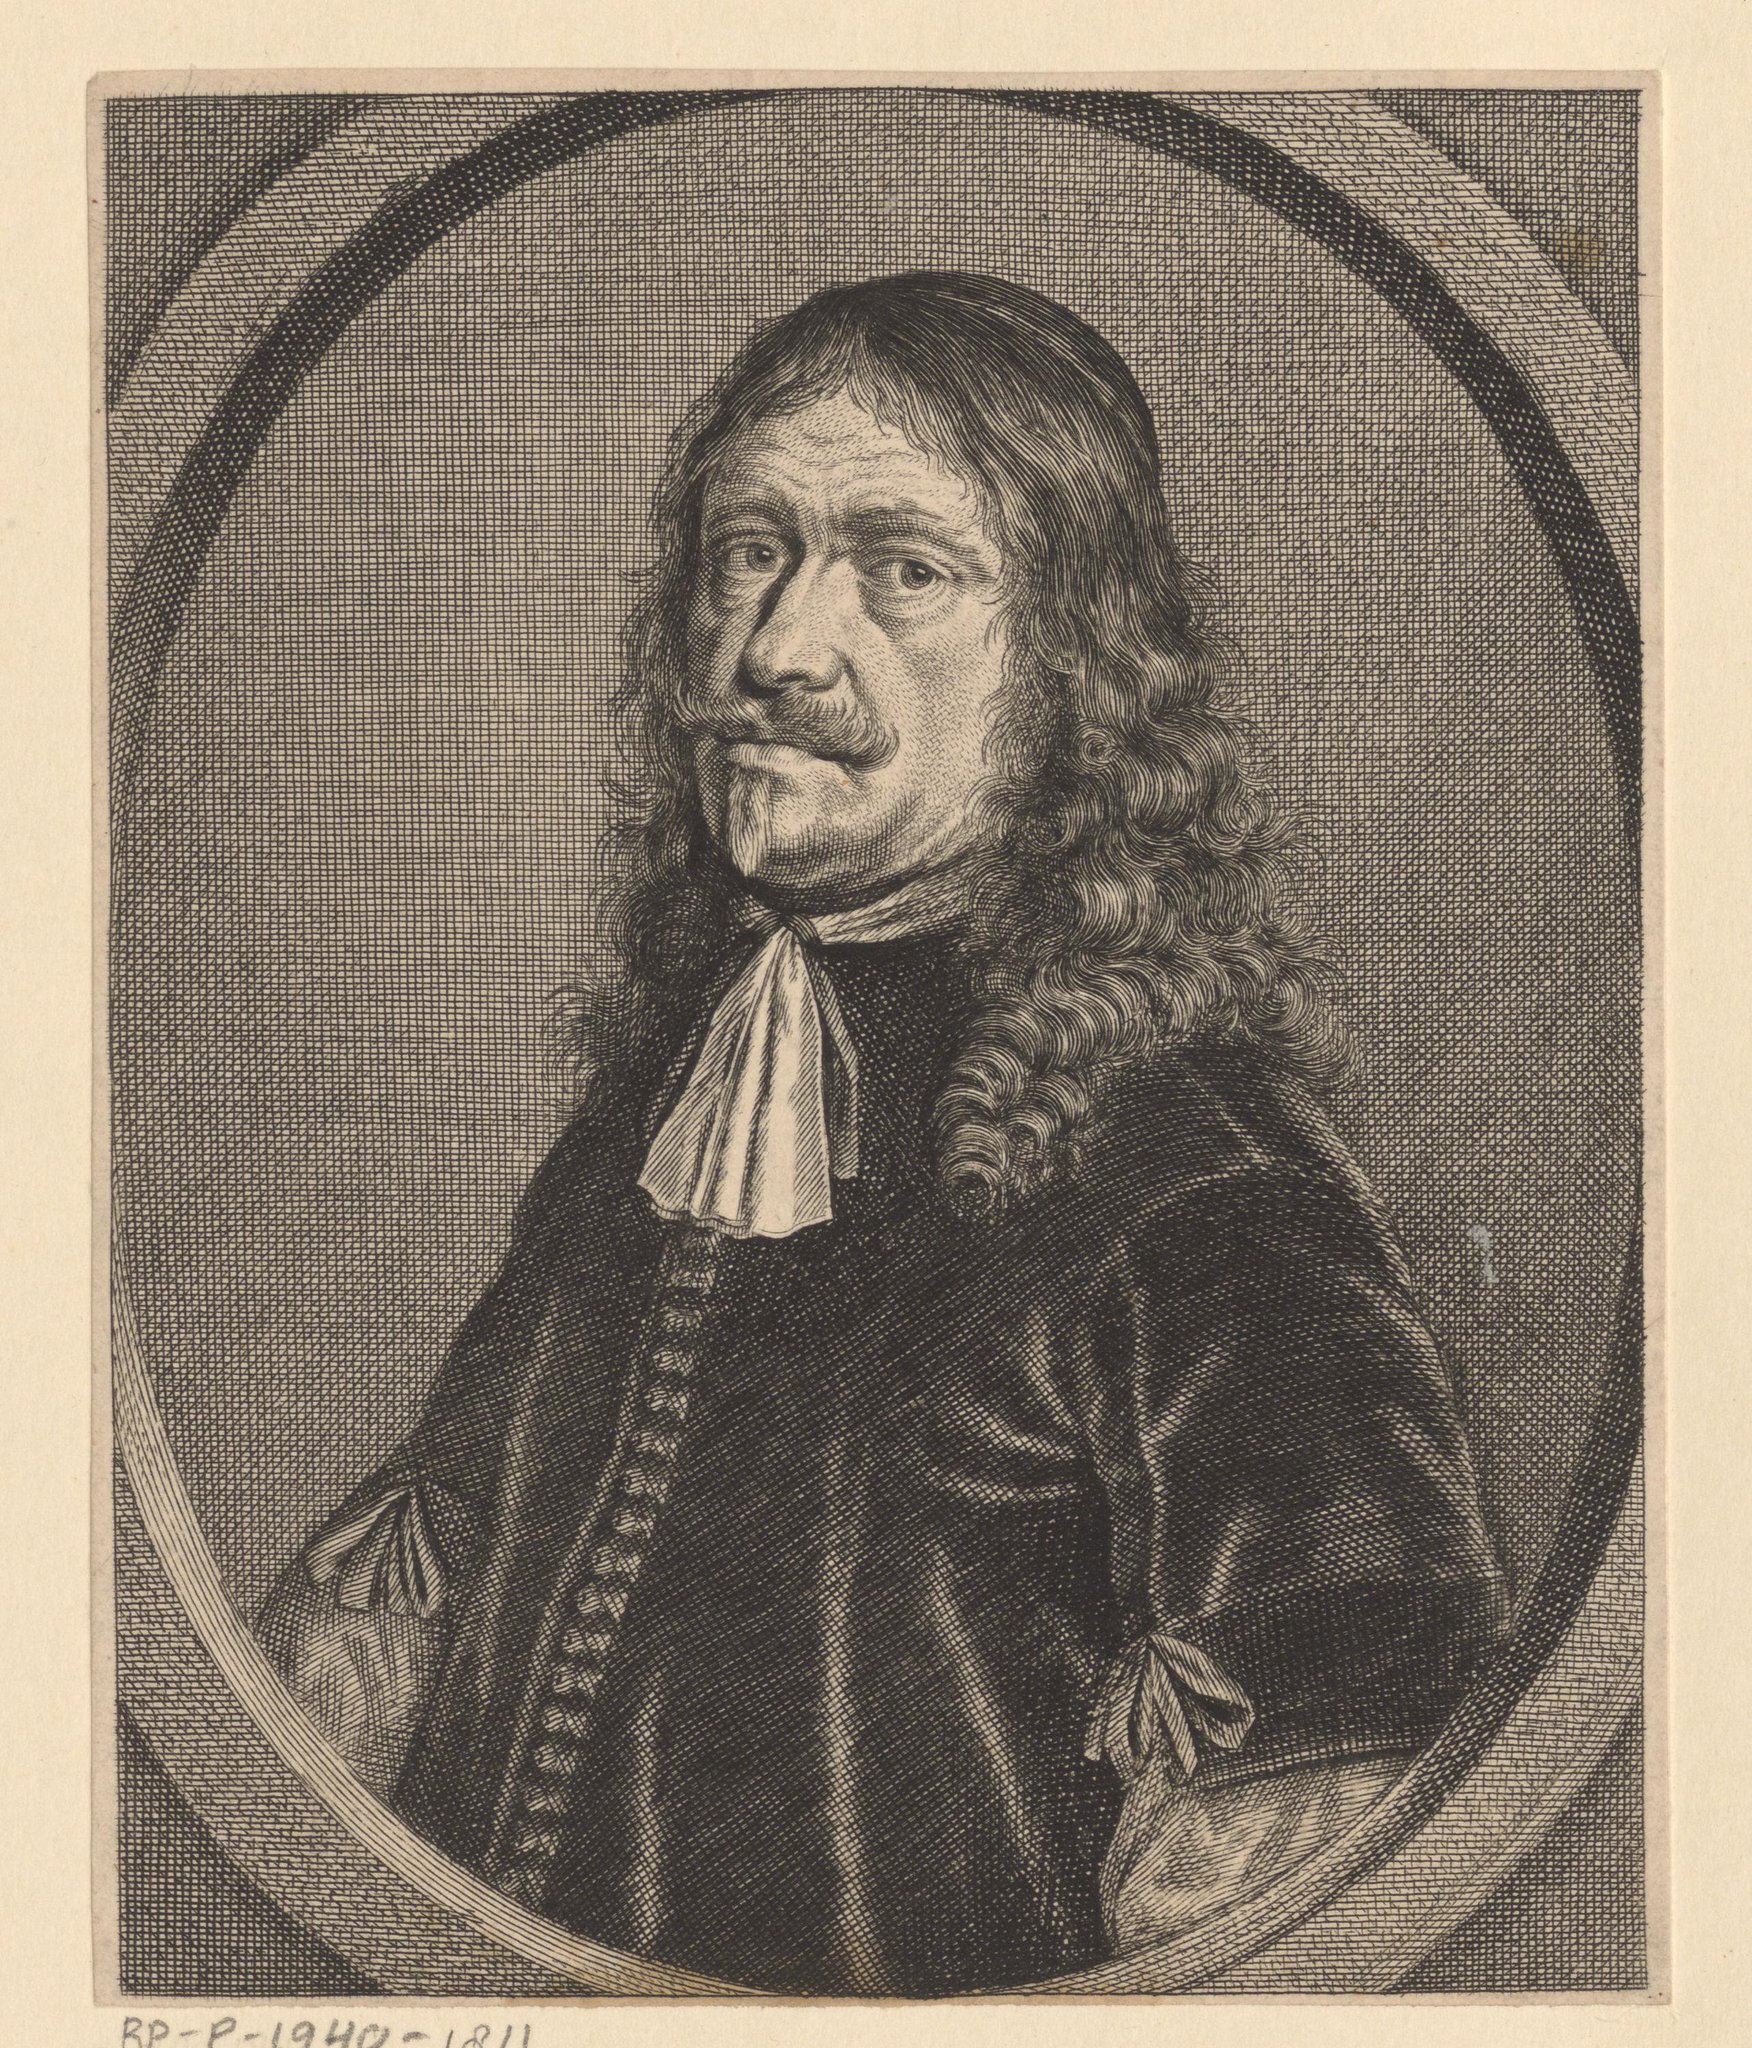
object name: print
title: Portret van Simon Peter Tilemann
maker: christiaan hagen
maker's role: draughtsman, print maker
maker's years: 1635-1707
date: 1668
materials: paper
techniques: engraving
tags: vienna, painter, simon peter tilemann, historical persons, portrait, self-portrait of painter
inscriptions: collector's mark: Lugt 2228, collector's mark: Lugt 2760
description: Op het opzetvel is het originele onderschrift dat bij deze prent is weggesneden bijgevoegd in boekdruk.